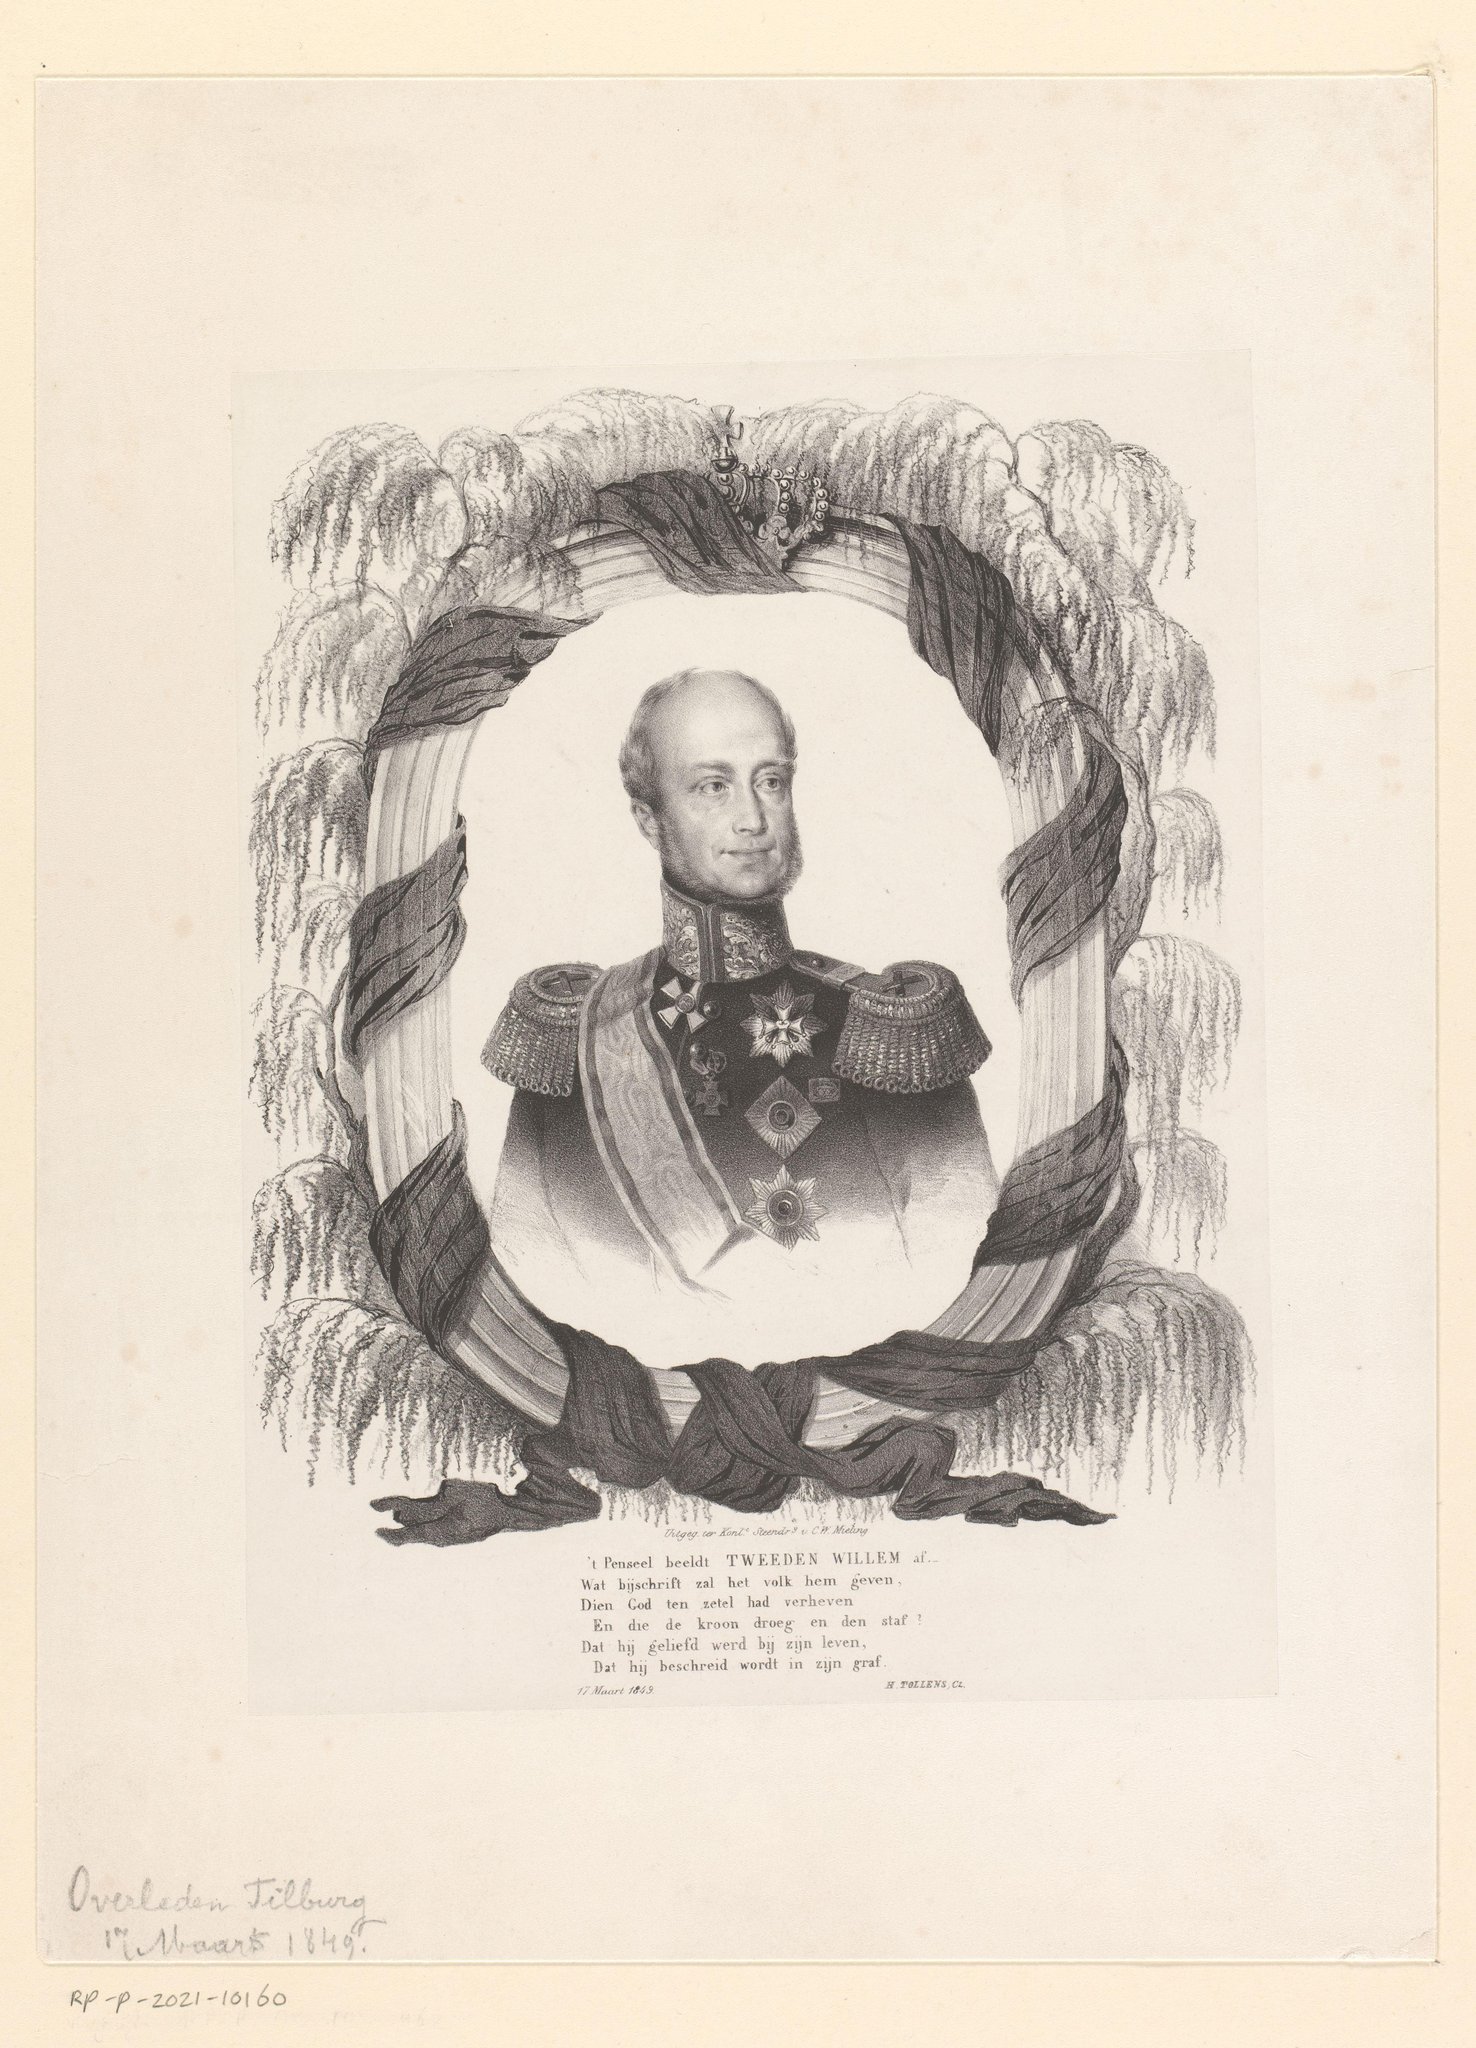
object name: print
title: Portret van Willem II, koning der Nederlanden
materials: paper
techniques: lithograph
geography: netherlands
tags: the hague, william ii of the netherlands, historical persons, (military) uniforms, king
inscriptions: number: ‘7189’, inscription: ‘Reeds bij Oranjeportretten Gm’, inscription: ‘Overleden Tilburg/ 17 Maart 1849.’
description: Portret van Willem II in een ovaal met treurwilgtakken en rouwfloers. Midden boven een kroon. Onder het portret een zesregelig Nederlands vers.